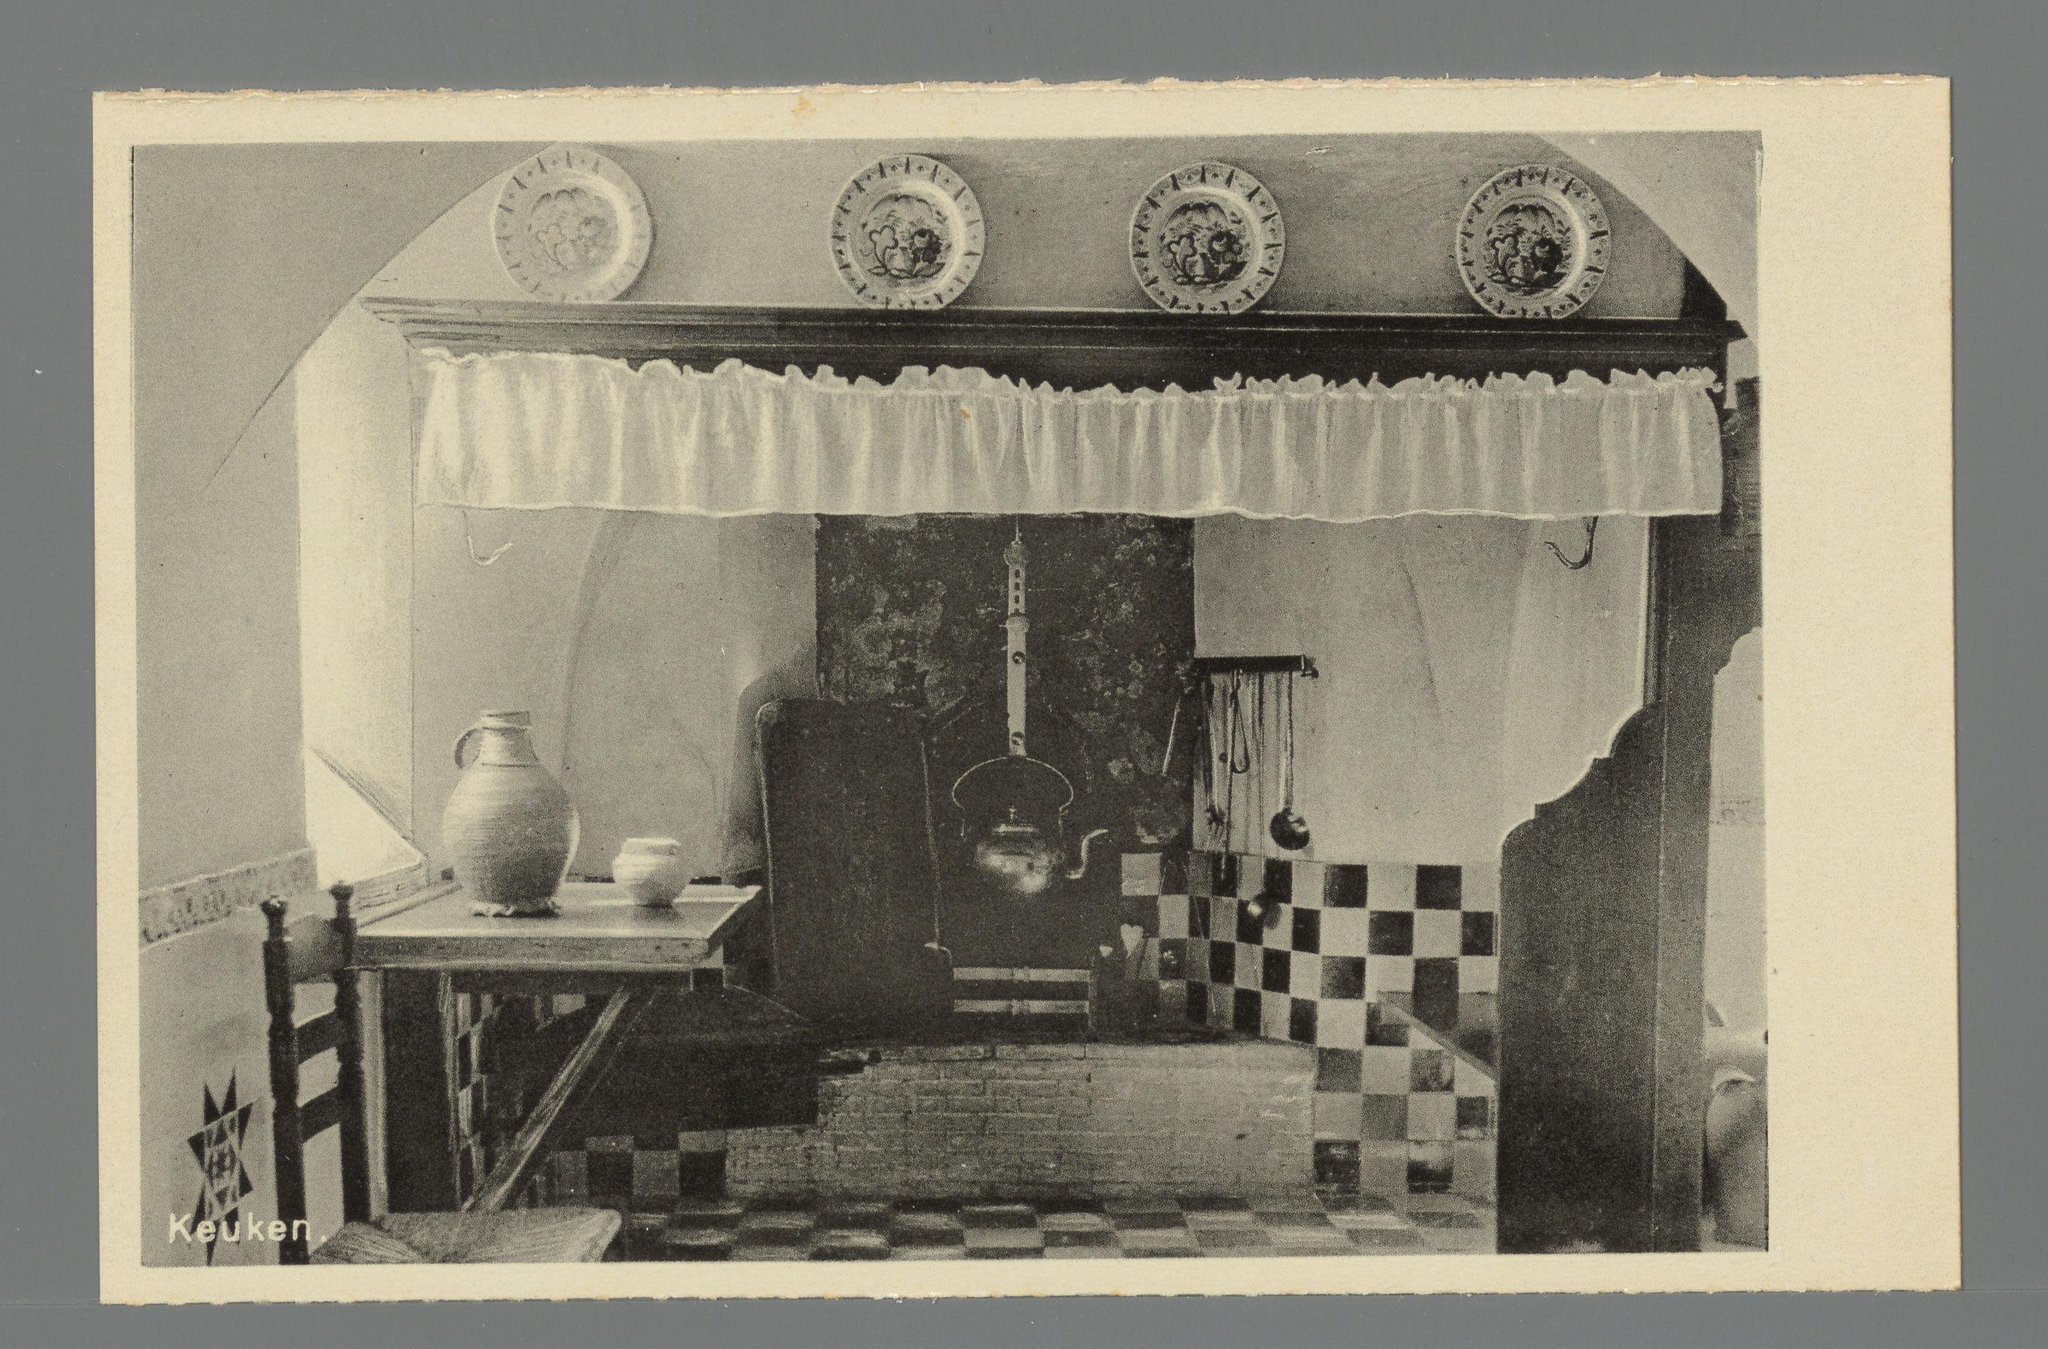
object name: ansichtkaart, prentbriefkaart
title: Keuken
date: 1913-1950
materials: cardboard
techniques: photograph, writing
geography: marssum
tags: kitchen, permanent exhibition, museum